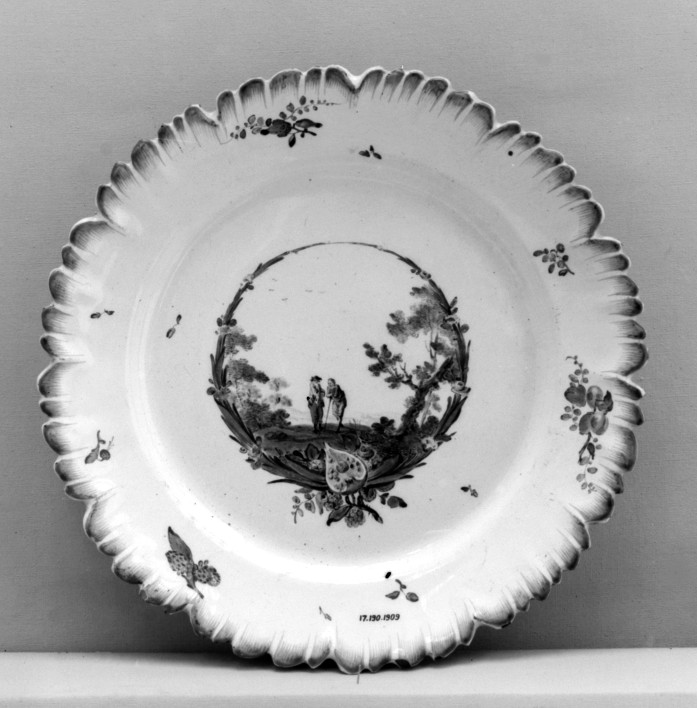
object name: plate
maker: fidelle duvivier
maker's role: decorator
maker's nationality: french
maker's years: 1740-1796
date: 1753-1795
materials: faience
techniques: glazing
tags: human figures,trees